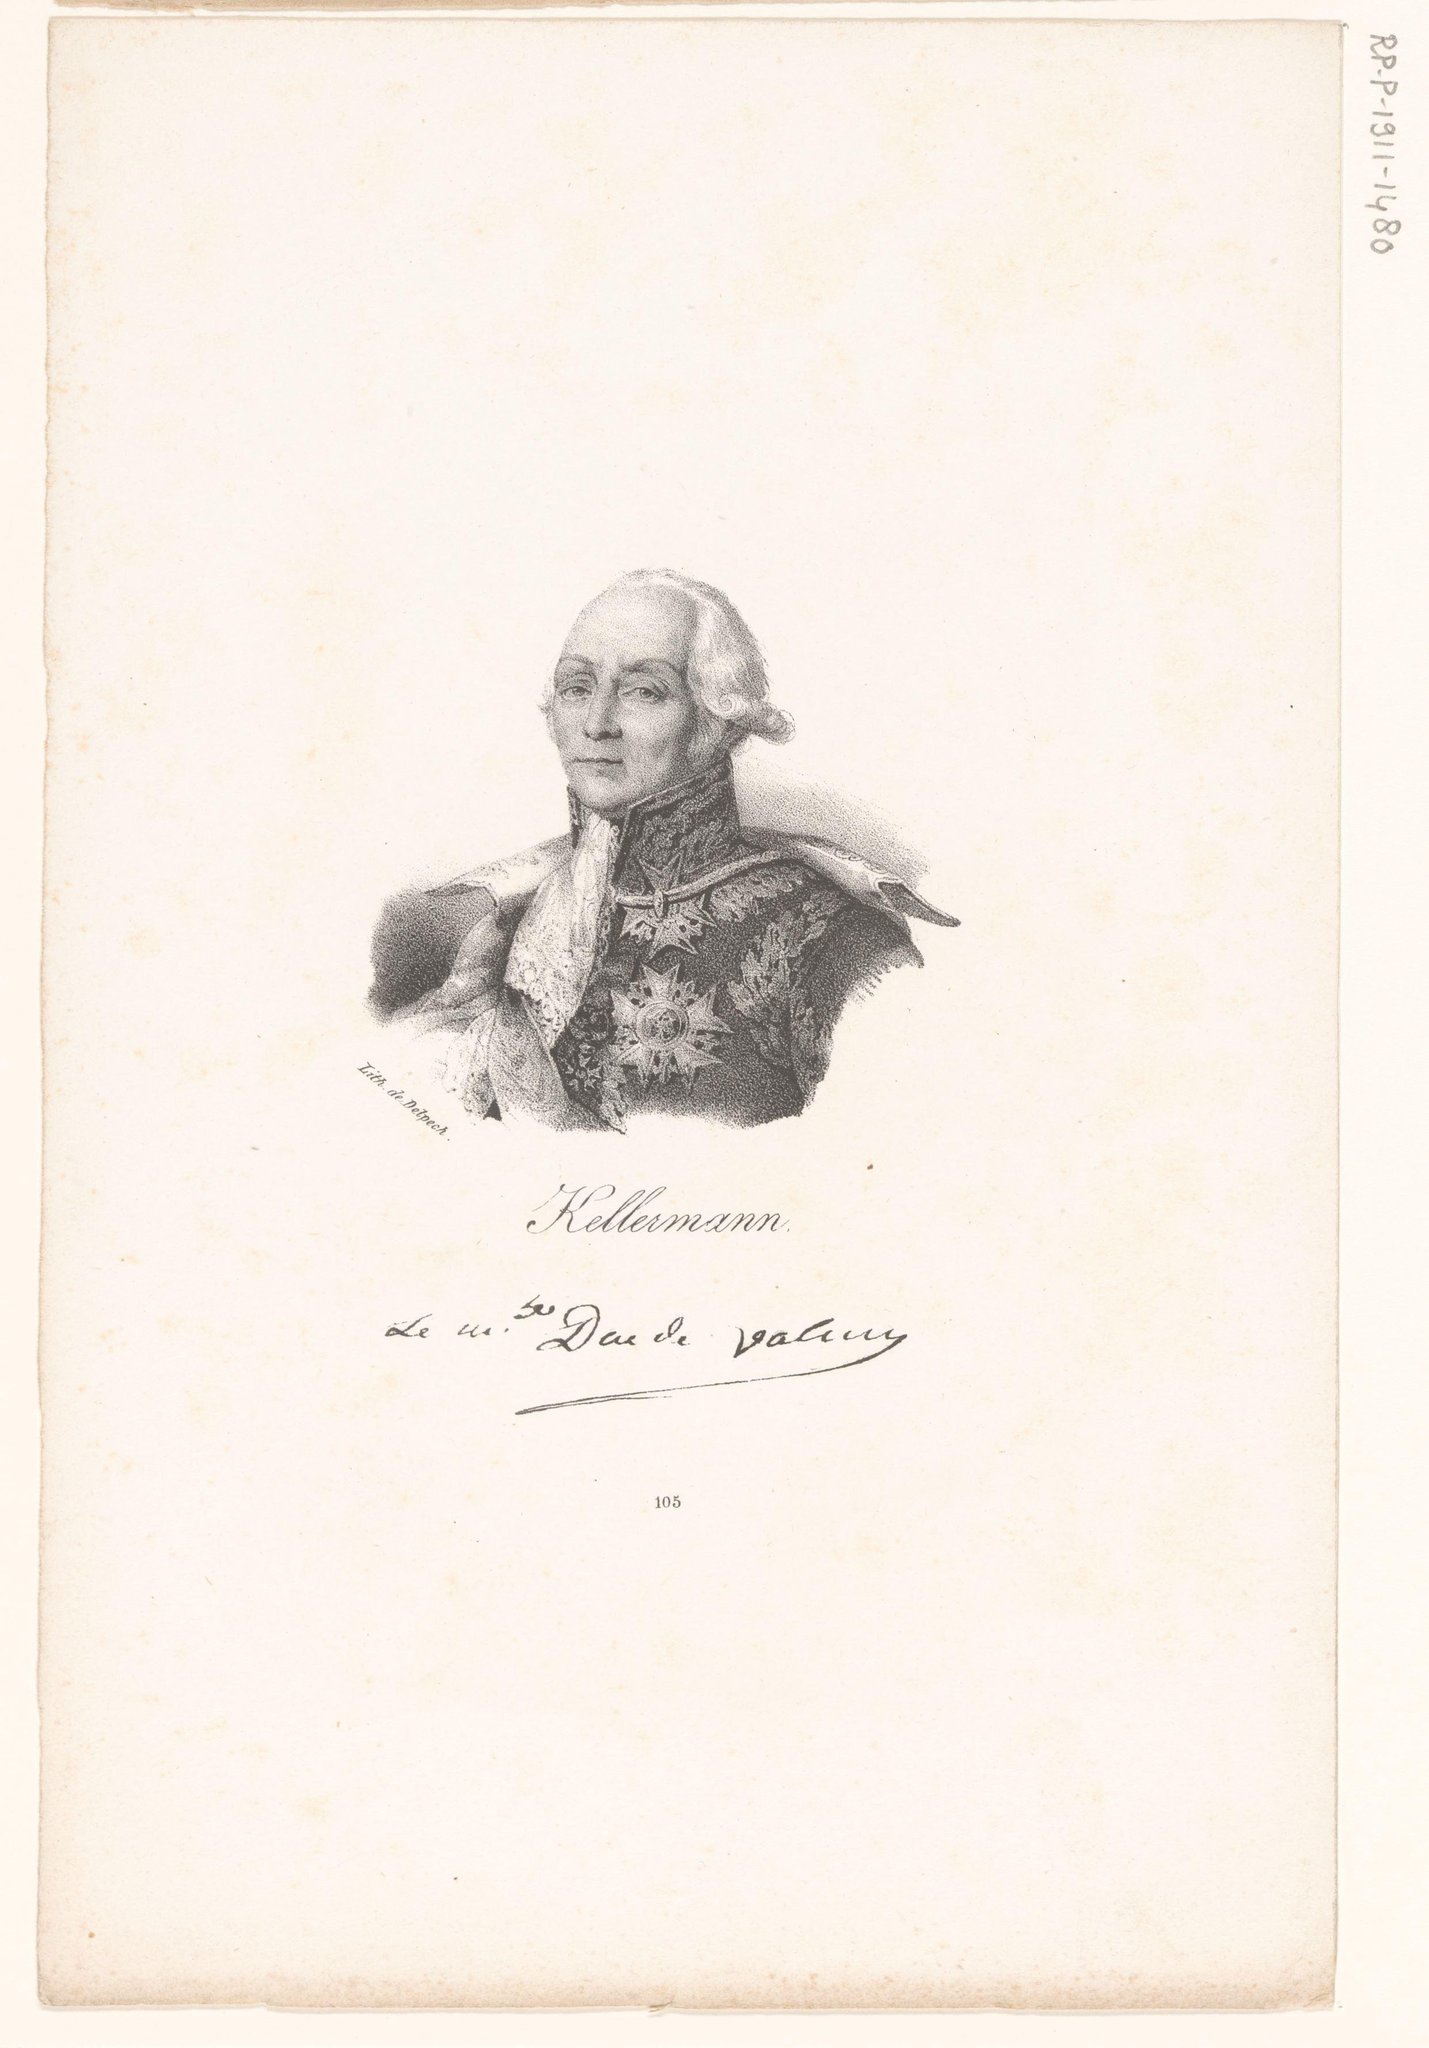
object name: print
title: Kellermann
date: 1818-1842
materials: paper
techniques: lithograph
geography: paris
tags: paris, politician, historical persons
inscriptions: collector's mark: Lugt 2228a